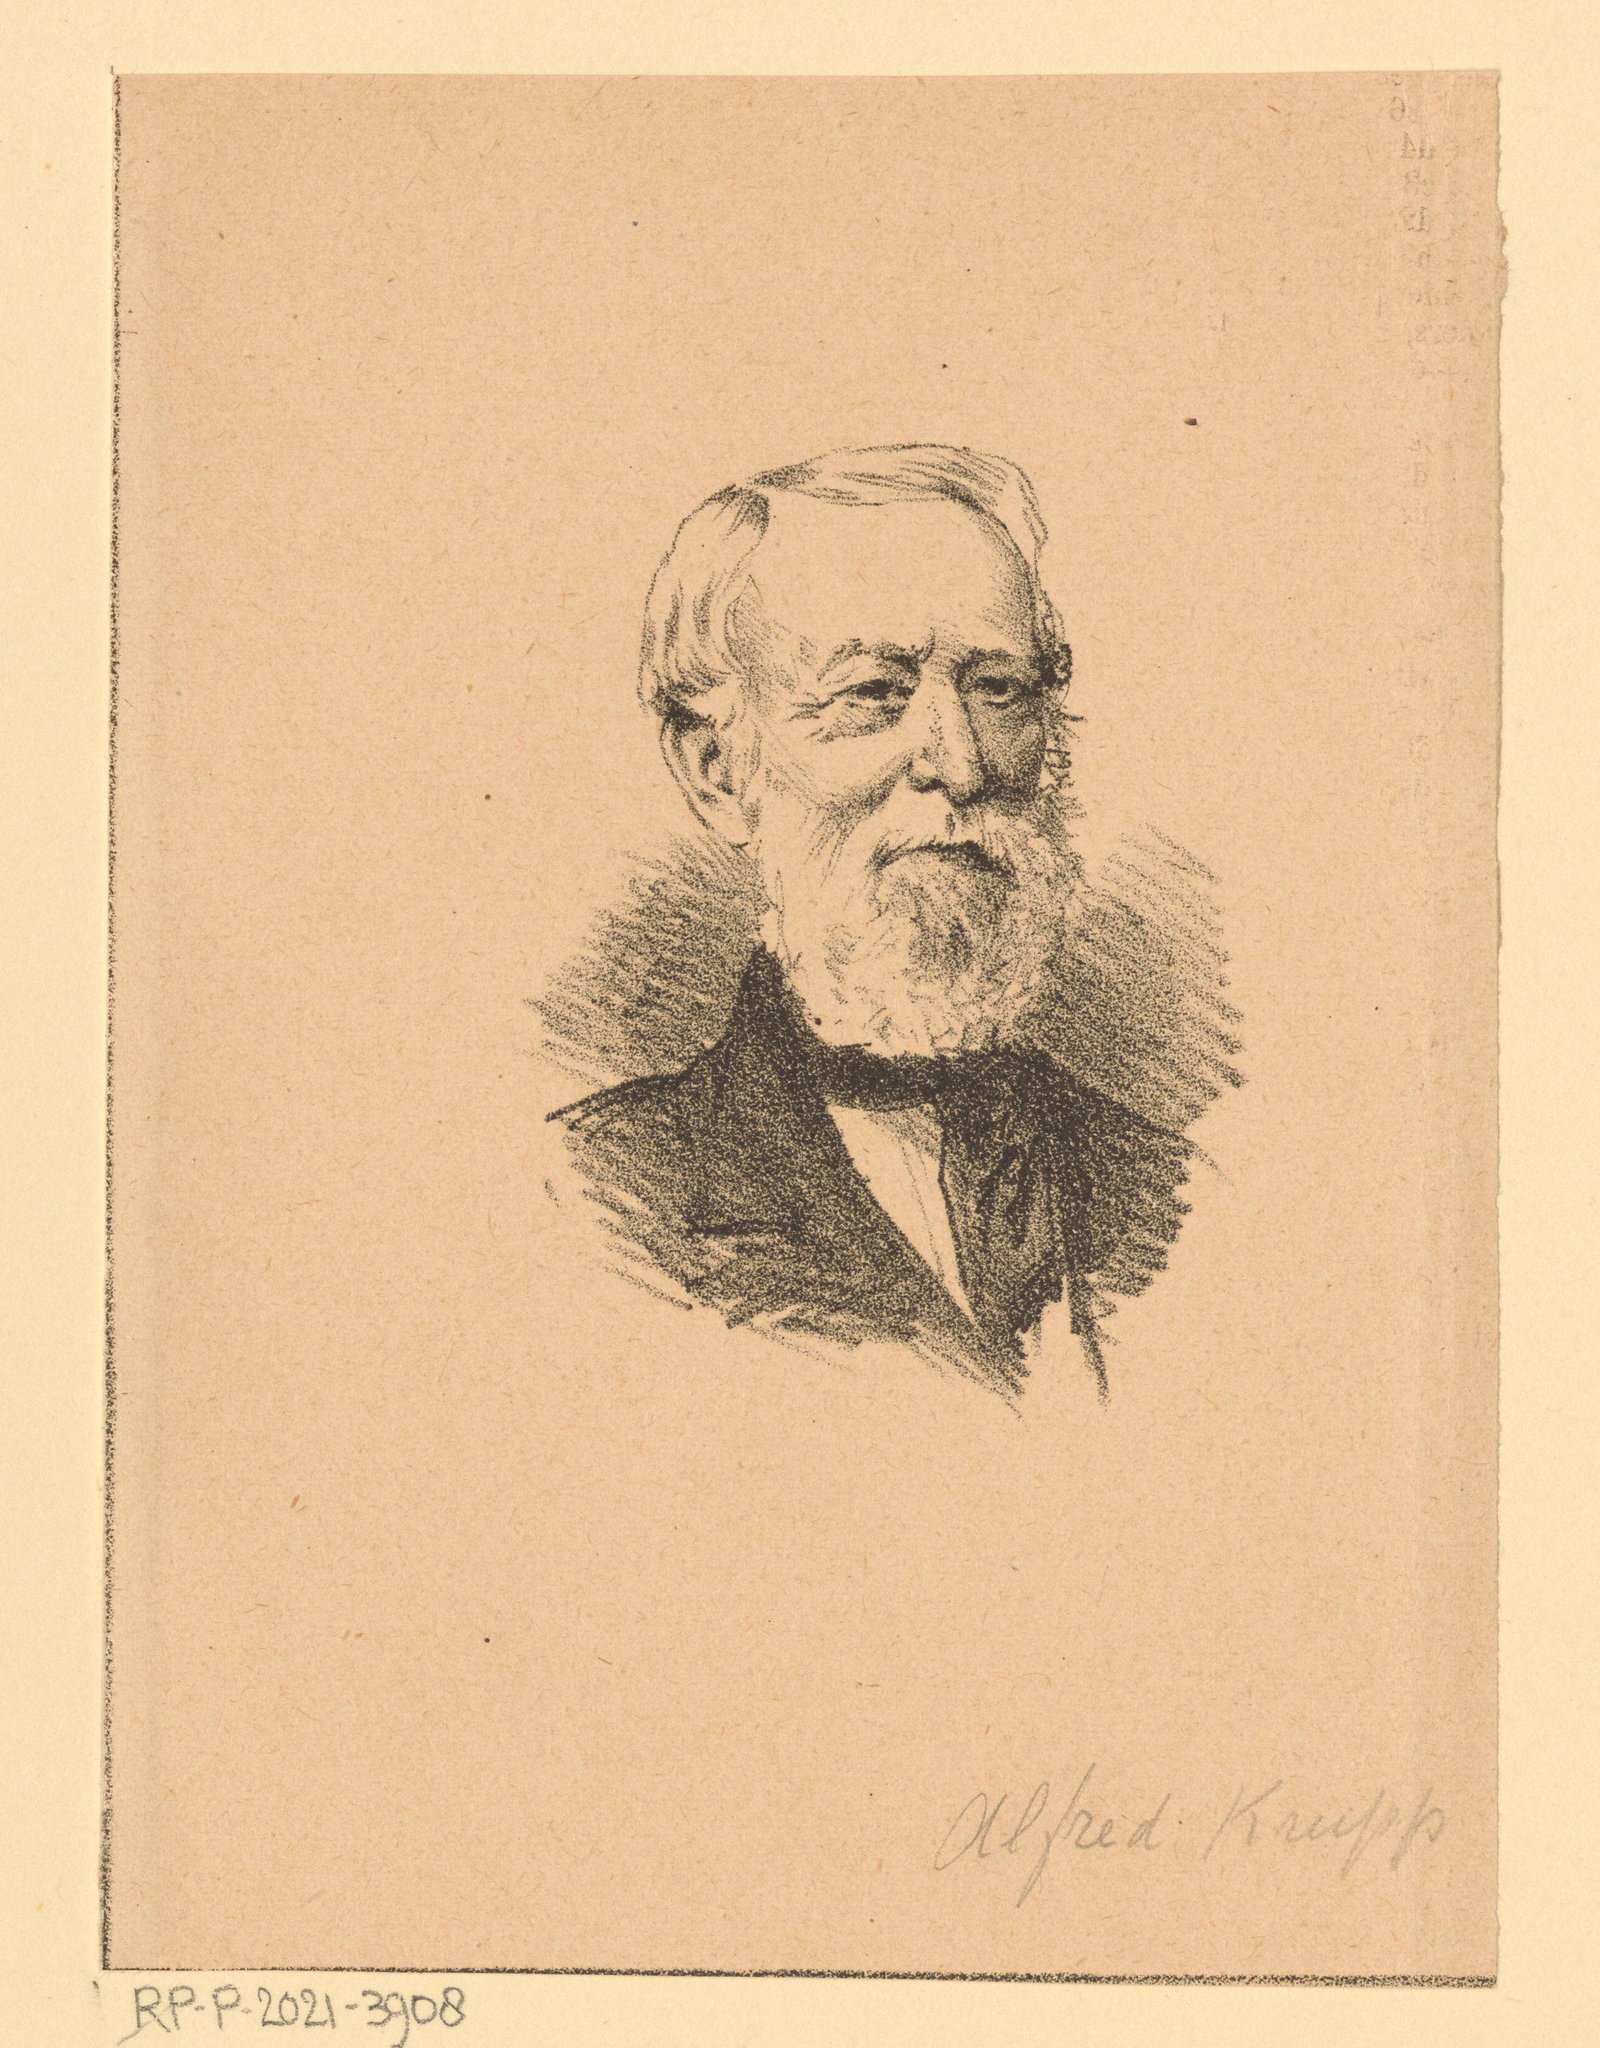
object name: print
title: Portret van Alfred Krupp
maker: Anonymous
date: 1862-1899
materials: paper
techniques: lithograph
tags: essen, historical persons